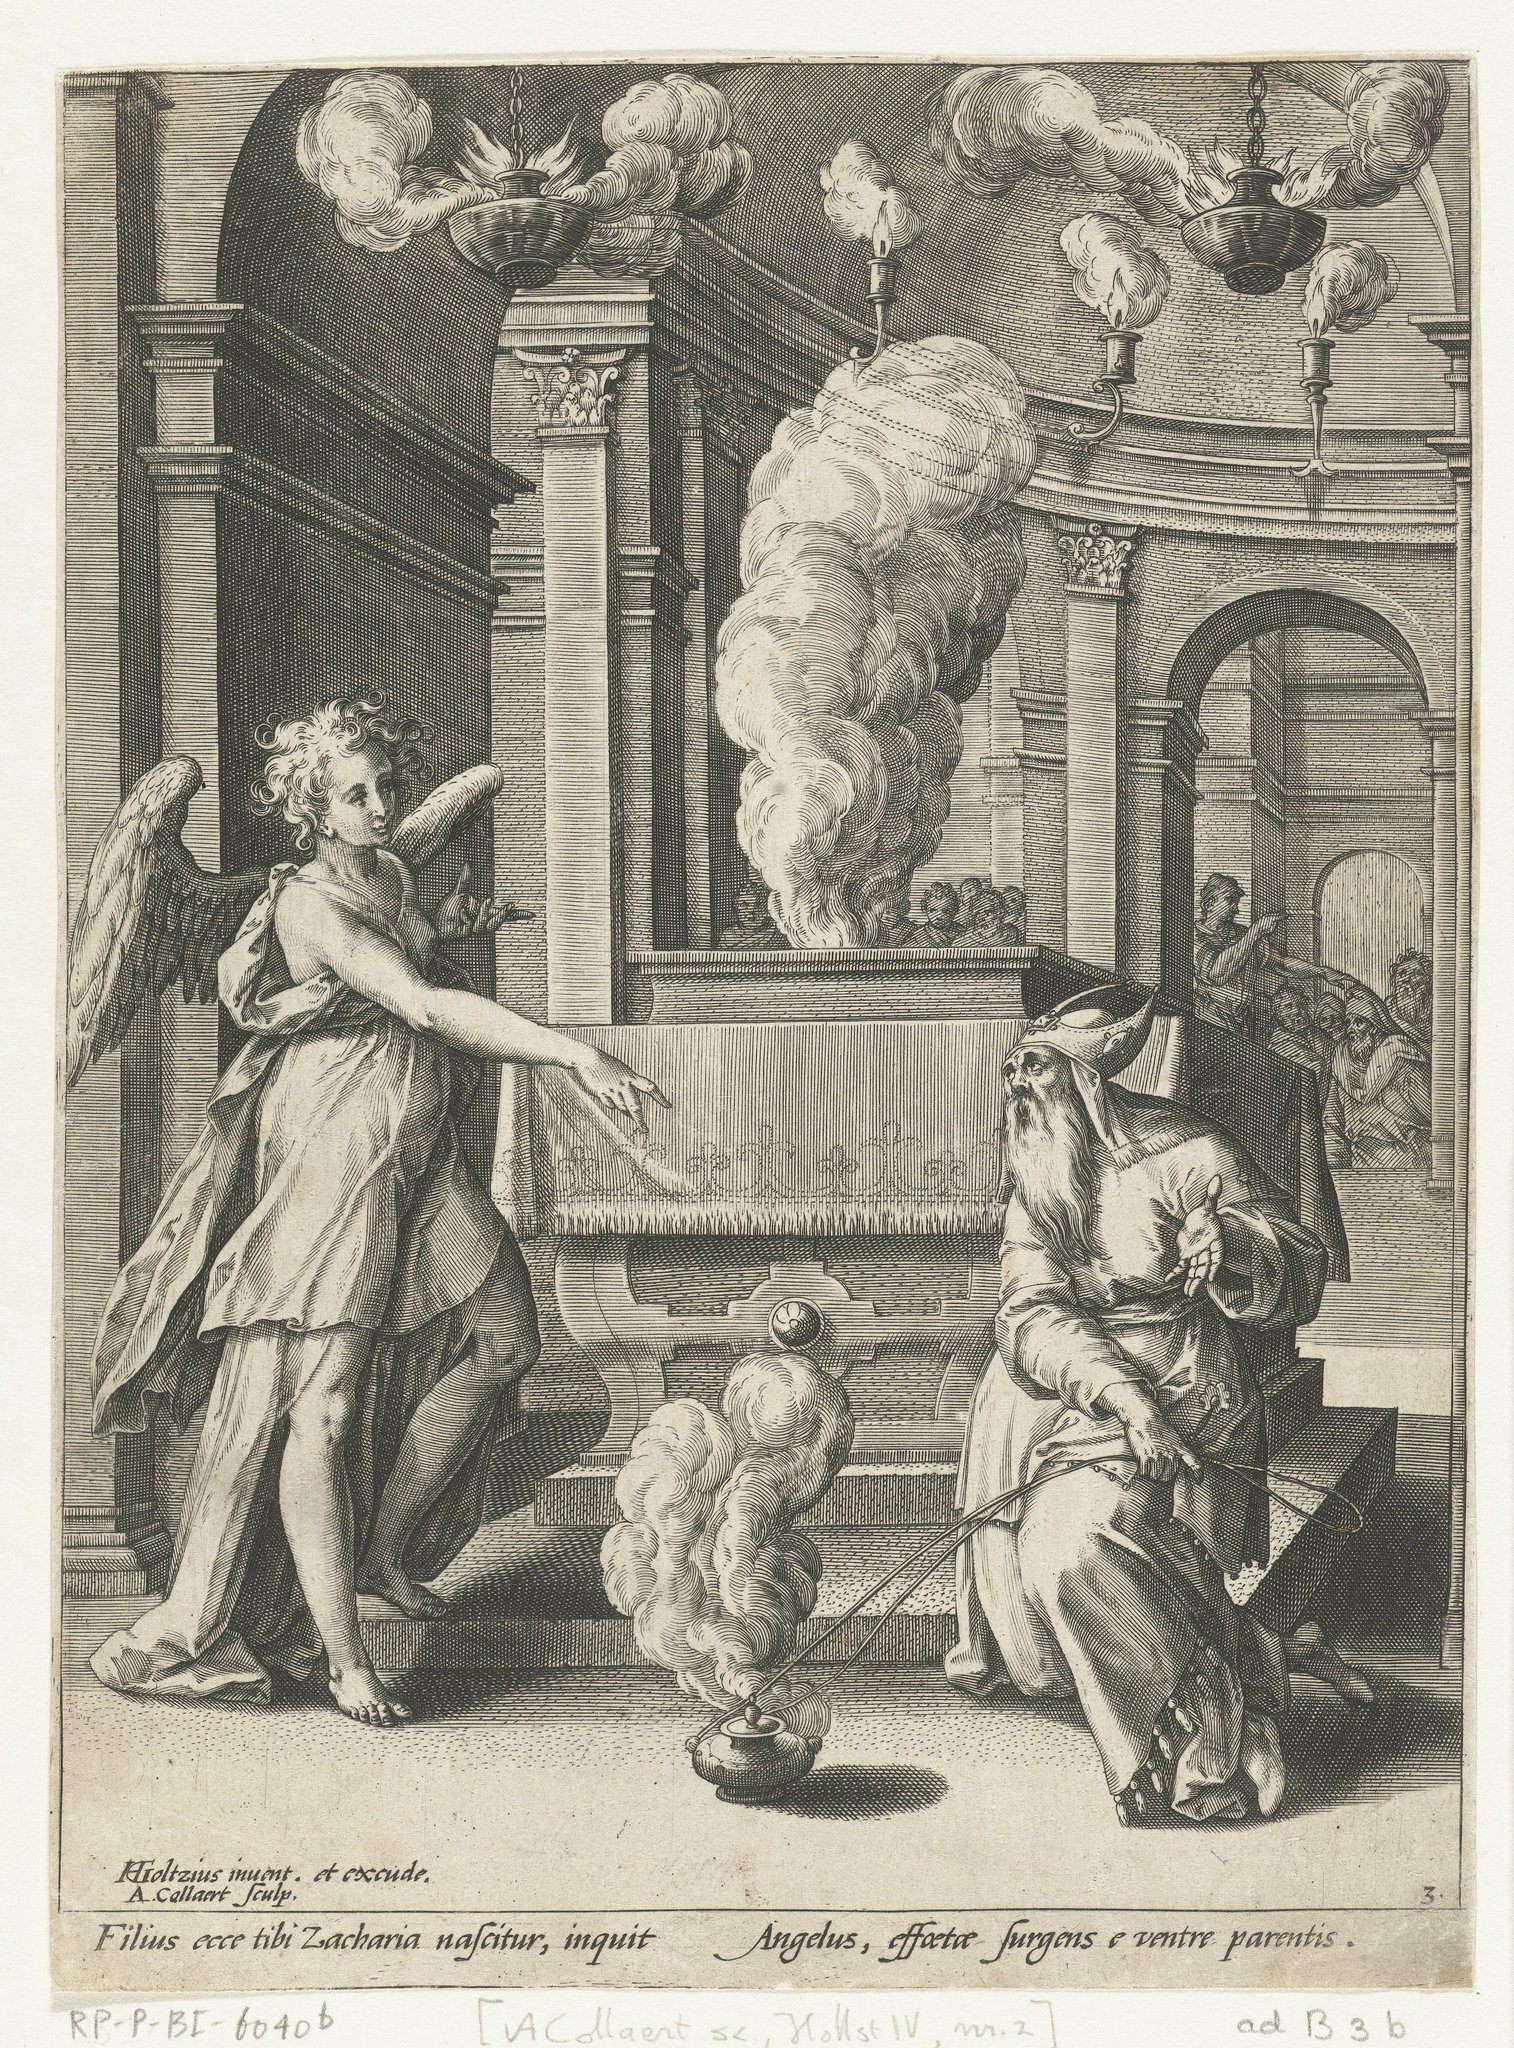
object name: print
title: Annunciaties uit de bijbel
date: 1586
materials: paper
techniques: engraving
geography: haarlem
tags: annunciation of the birth of john the baptist to zacharias: while he is offering incense in the temple an angel (gabriel) appears to him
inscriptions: signature and address: ‘HGoltzius inuent et excud./ A. Colaert sculp.’, collector's mark: Lugt 240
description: Goltzius heeft deze prent ontworpen en uitgegeven. Het vervaardigen van de plaat is echter uitgevoerd door Adriaen Collaert. Serie van zes, alle exemplaren aanwezig in het RPK. Jacobs, G.